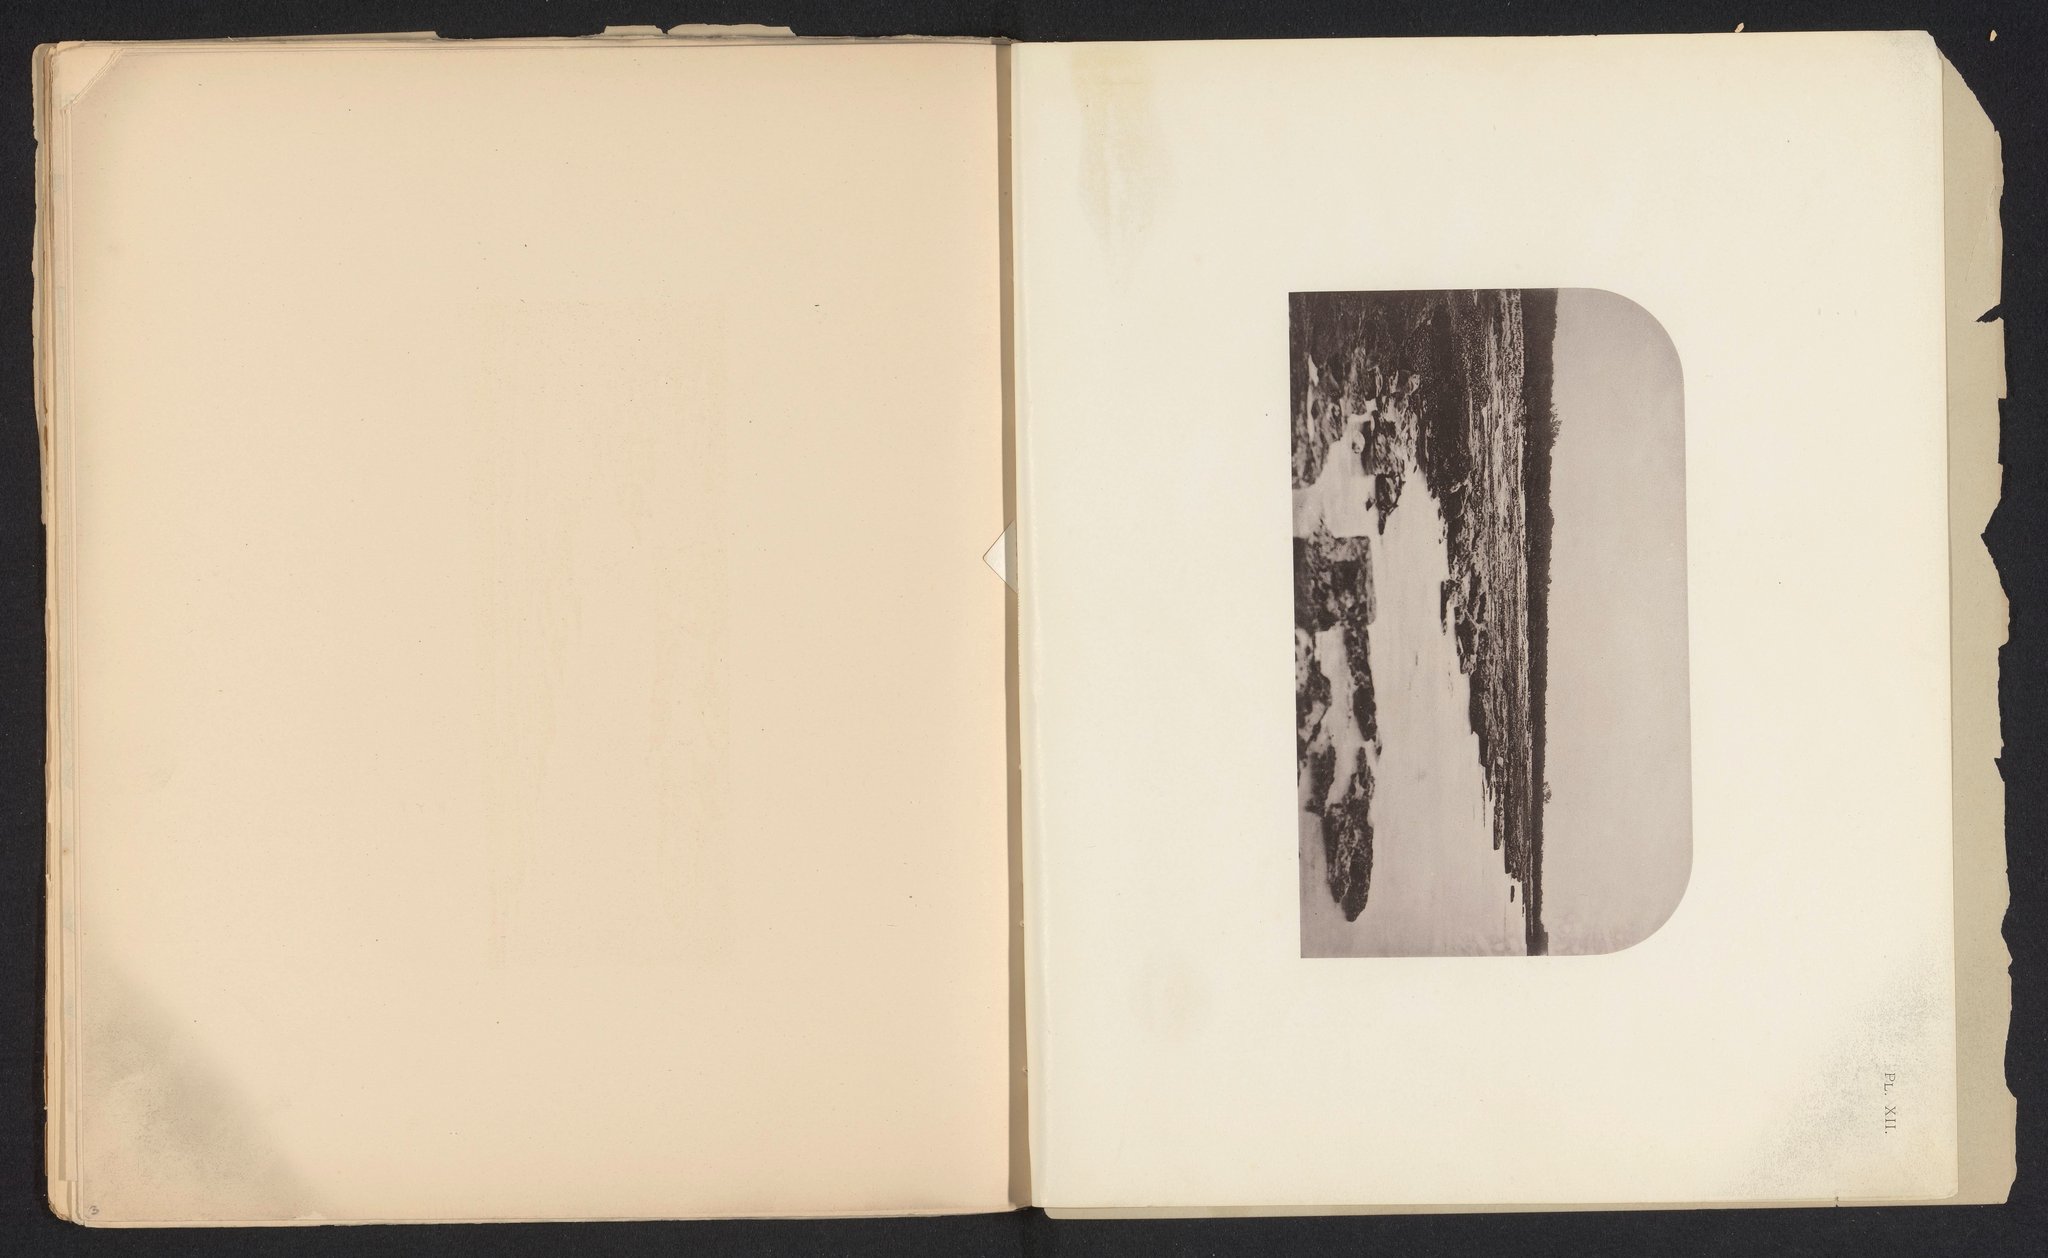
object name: photomechanical print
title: Gezicht op een strand met koraal op Key West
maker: Anonymous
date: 1875-1885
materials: paper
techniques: photograph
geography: florida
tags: island, coral island, beach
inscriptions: number: ‘Pl. XII.’